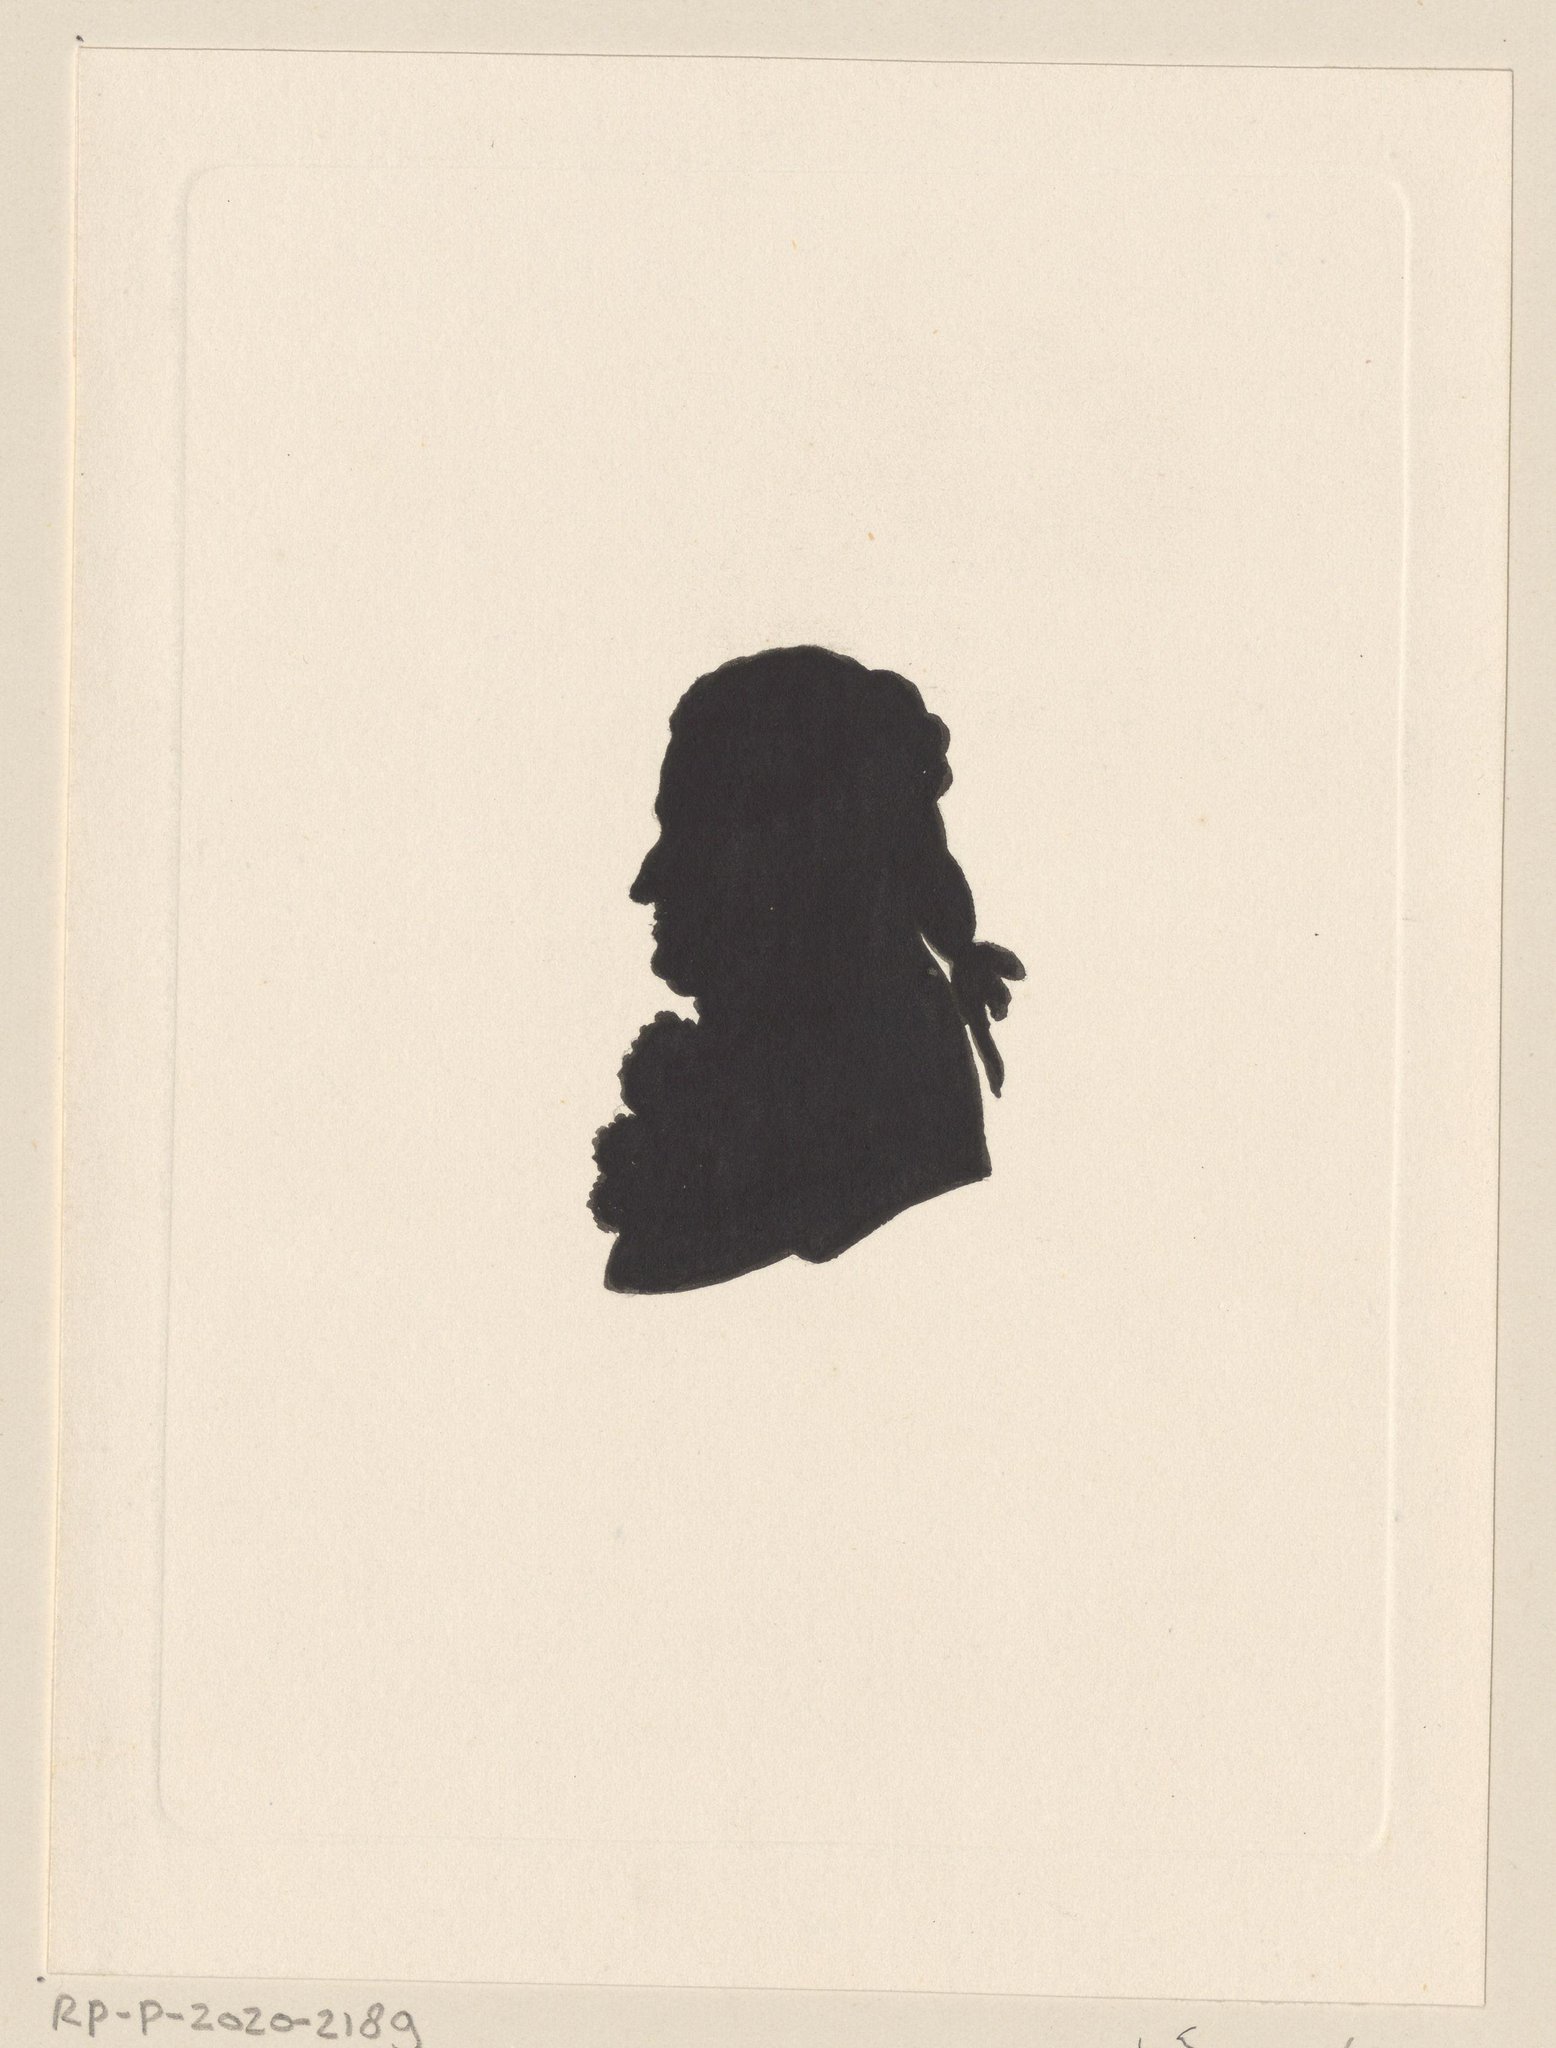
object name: print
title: Silhouetportret van Antonie Jacob van Doeveren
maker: Anonymous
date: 1780-1824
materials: ink, paper, pencil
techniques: brush, etching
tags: historical persons, physician, doctor